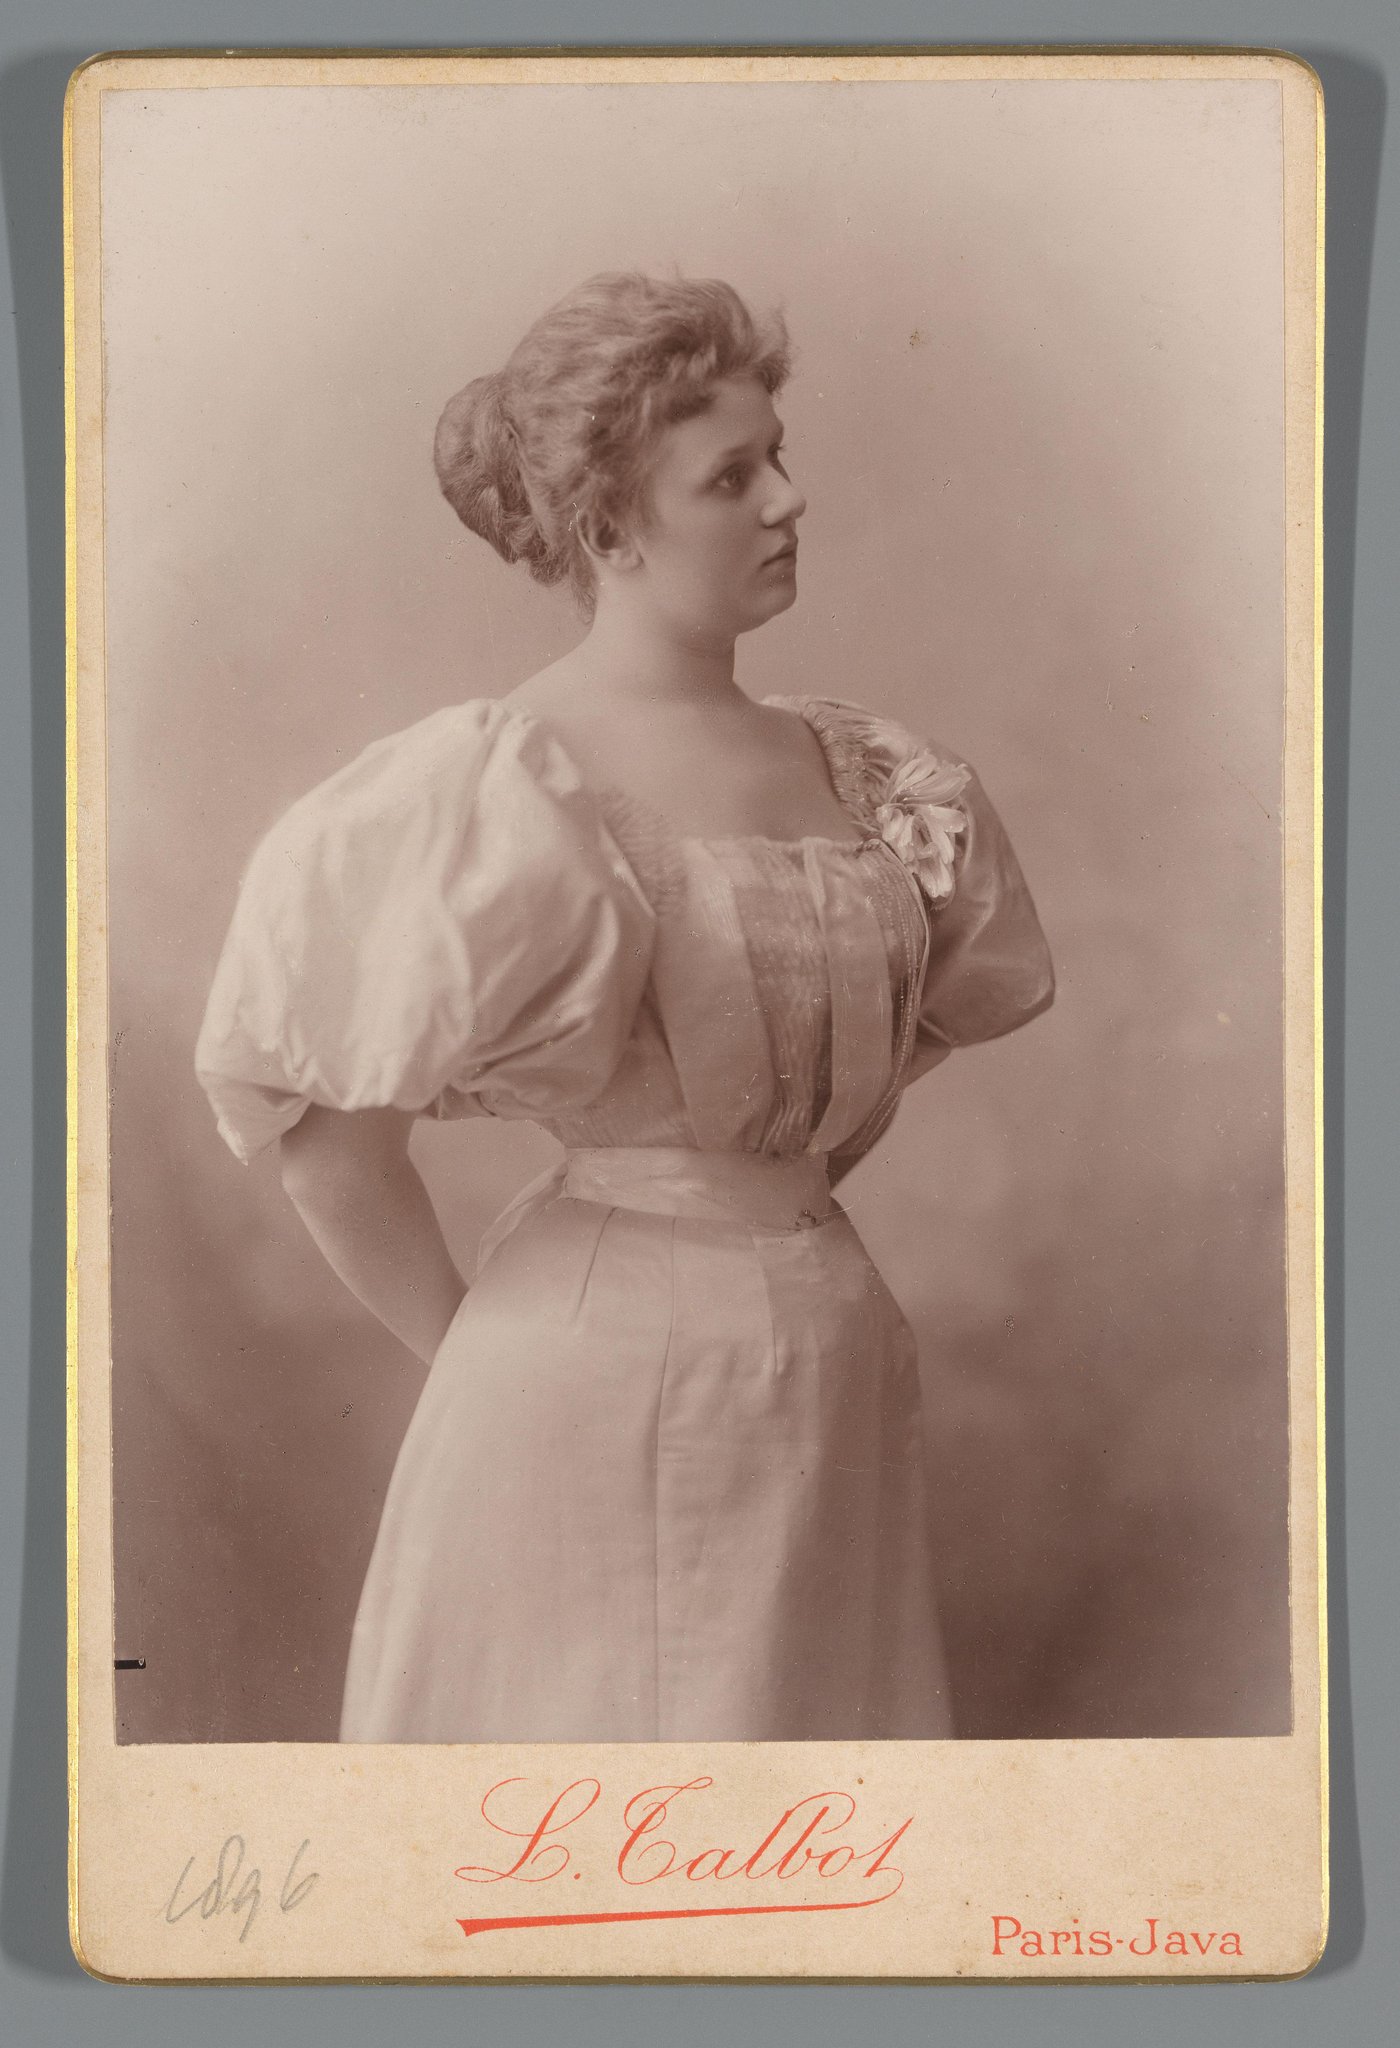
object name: cabinet photograph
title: Staande vrouw met handen op de rug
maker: louis joseph isidore talbot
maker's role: fotograaf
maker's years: 1852-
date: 1896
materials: cardboard, photographic support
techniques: albumen print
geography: java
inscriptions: inscription: ‘Moeder / Batavia / 1896’, date: ‘1896’, inscription: ‘L. Talbot / Paris.Java’, inscription: ‘MÉDAILLE D 'OR / L. Talbot / Paris-Java’